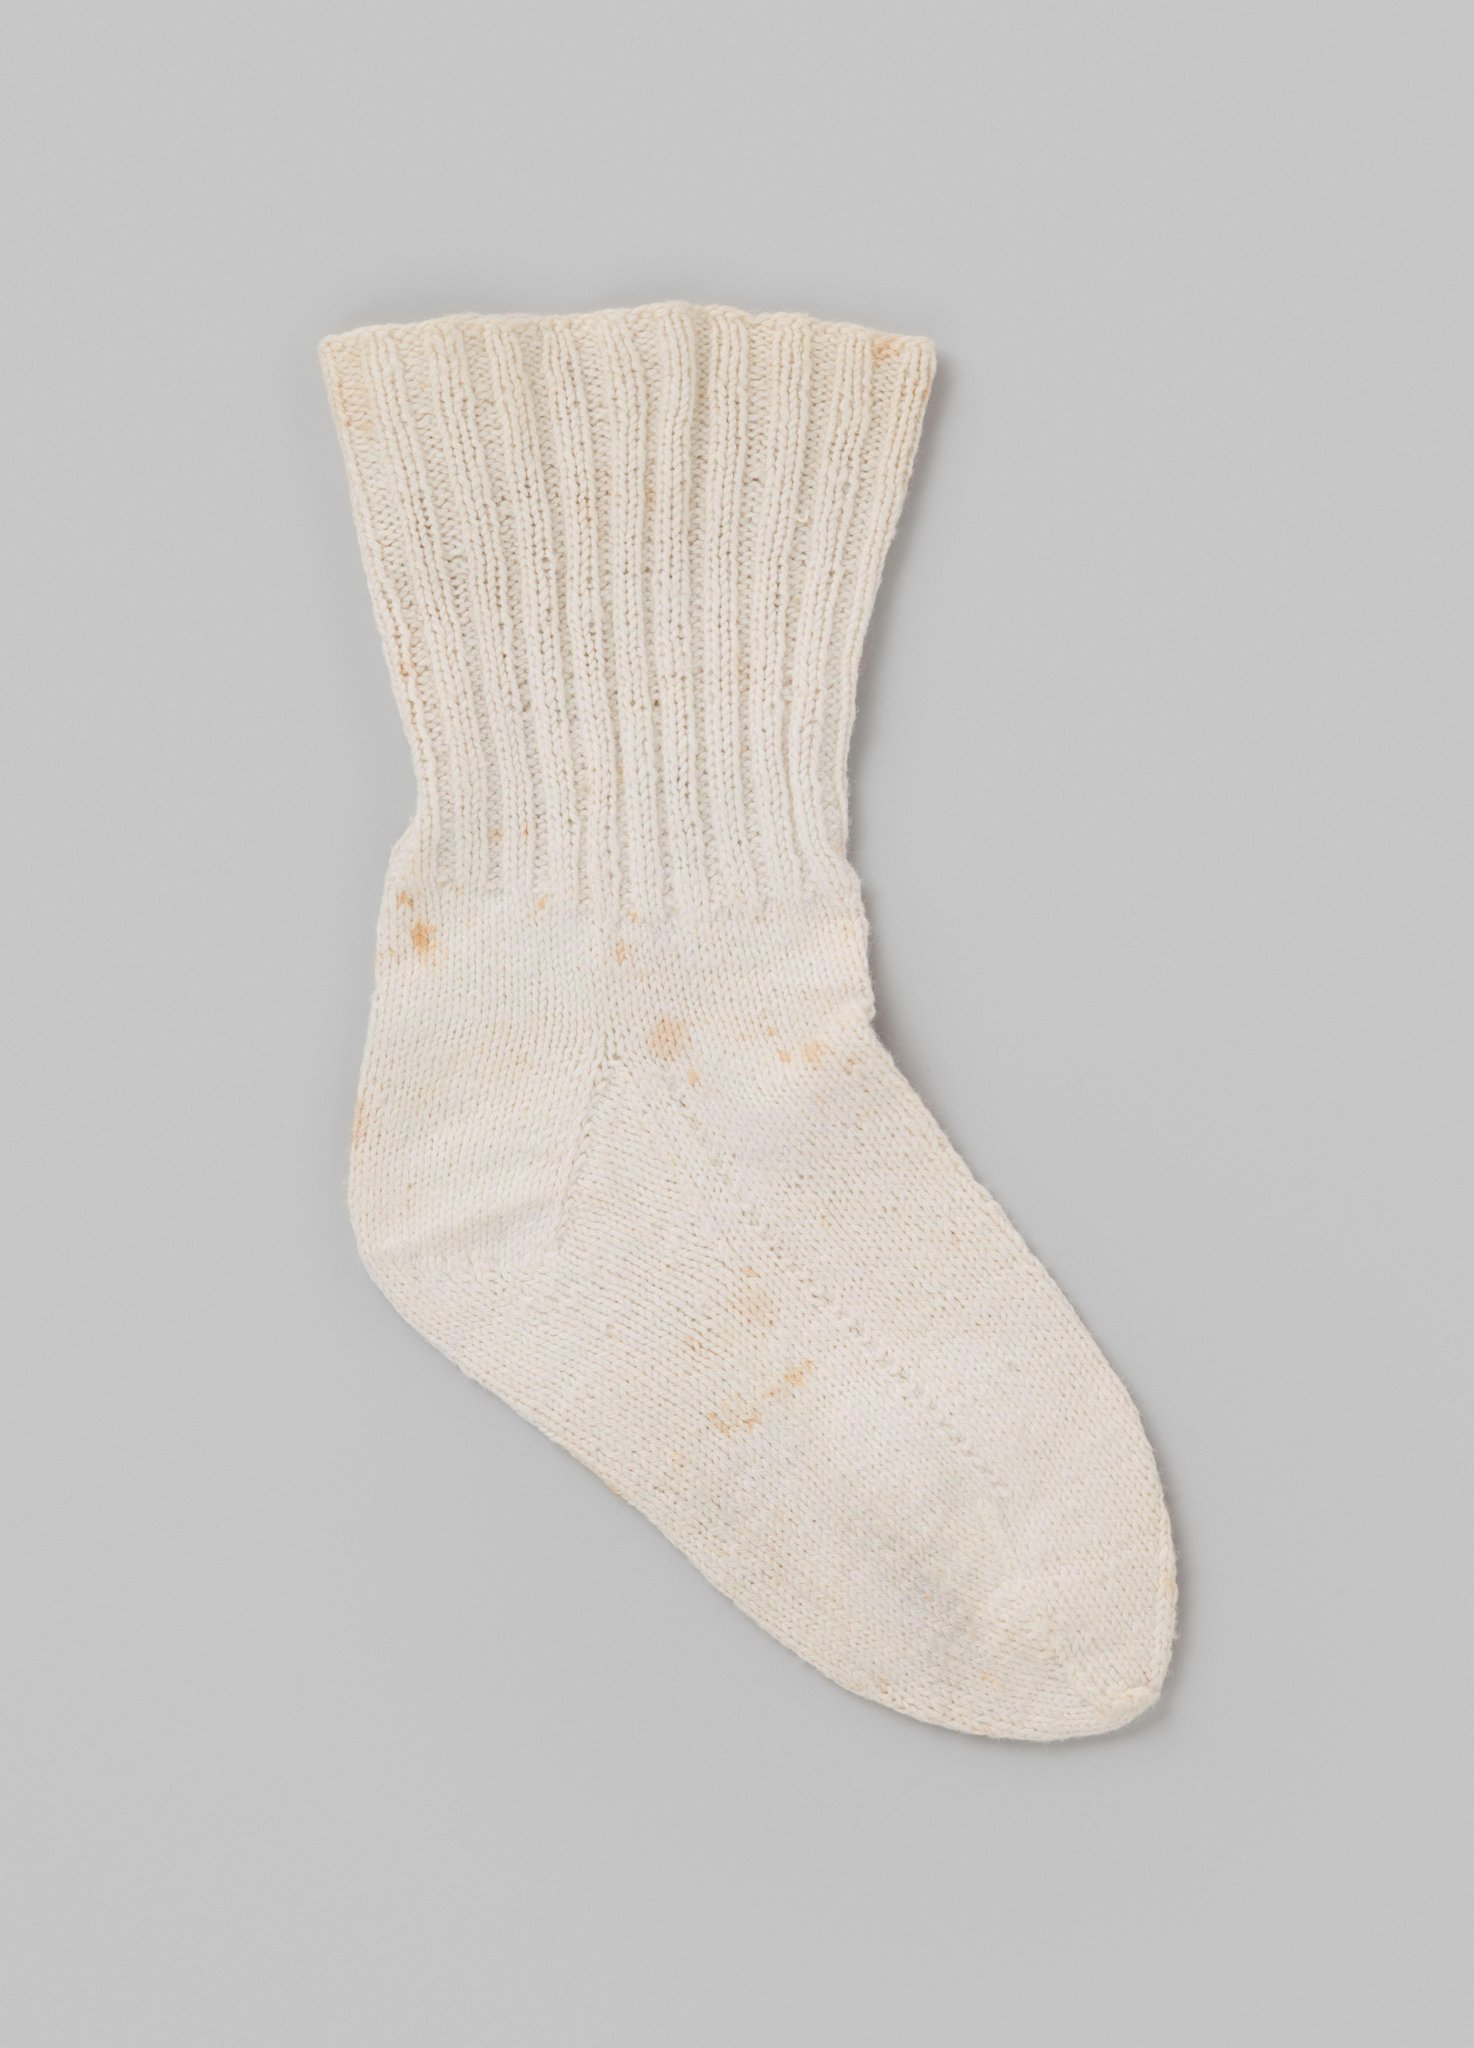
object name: childrenswear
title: Sok, wit gebreid, met staande ribbels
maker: Anonymous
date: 1879-1880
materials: cotton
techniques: knitting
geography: amsterdam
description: Witte gebreide sok, met staande ribbels.